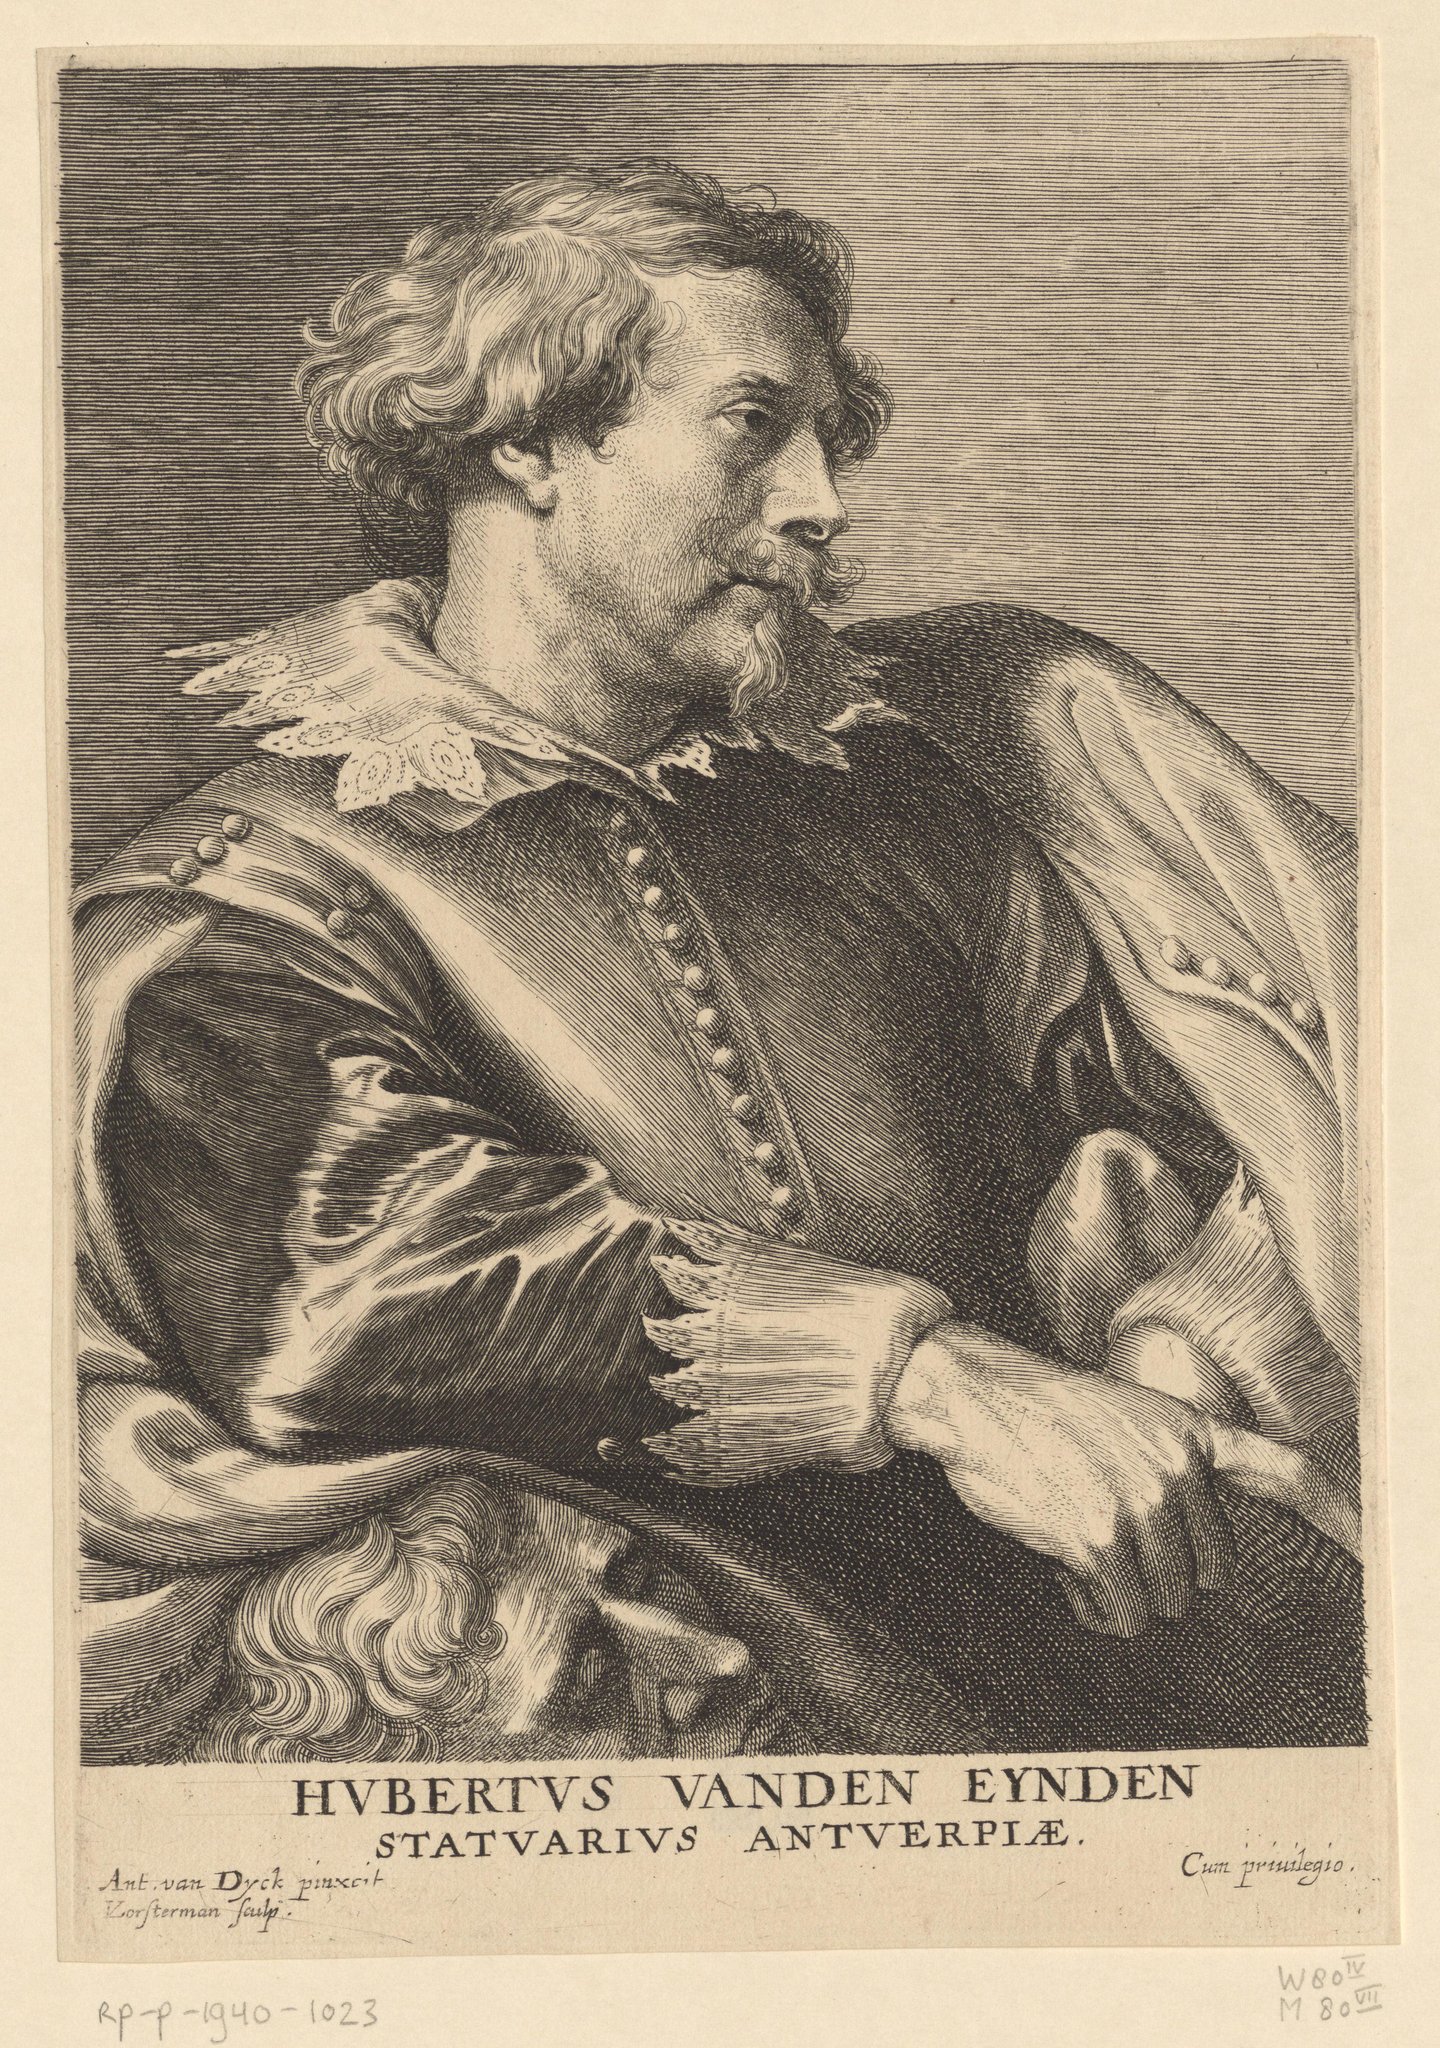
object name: print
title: Portret van Hubrecht van den Eynde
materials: paper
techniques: engraving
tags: antwerp, sculptor, portrait, self-portrait of sculptor, historical persons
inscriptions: collector's mark: Lugt 2760, collector's mark: Lugt 2166